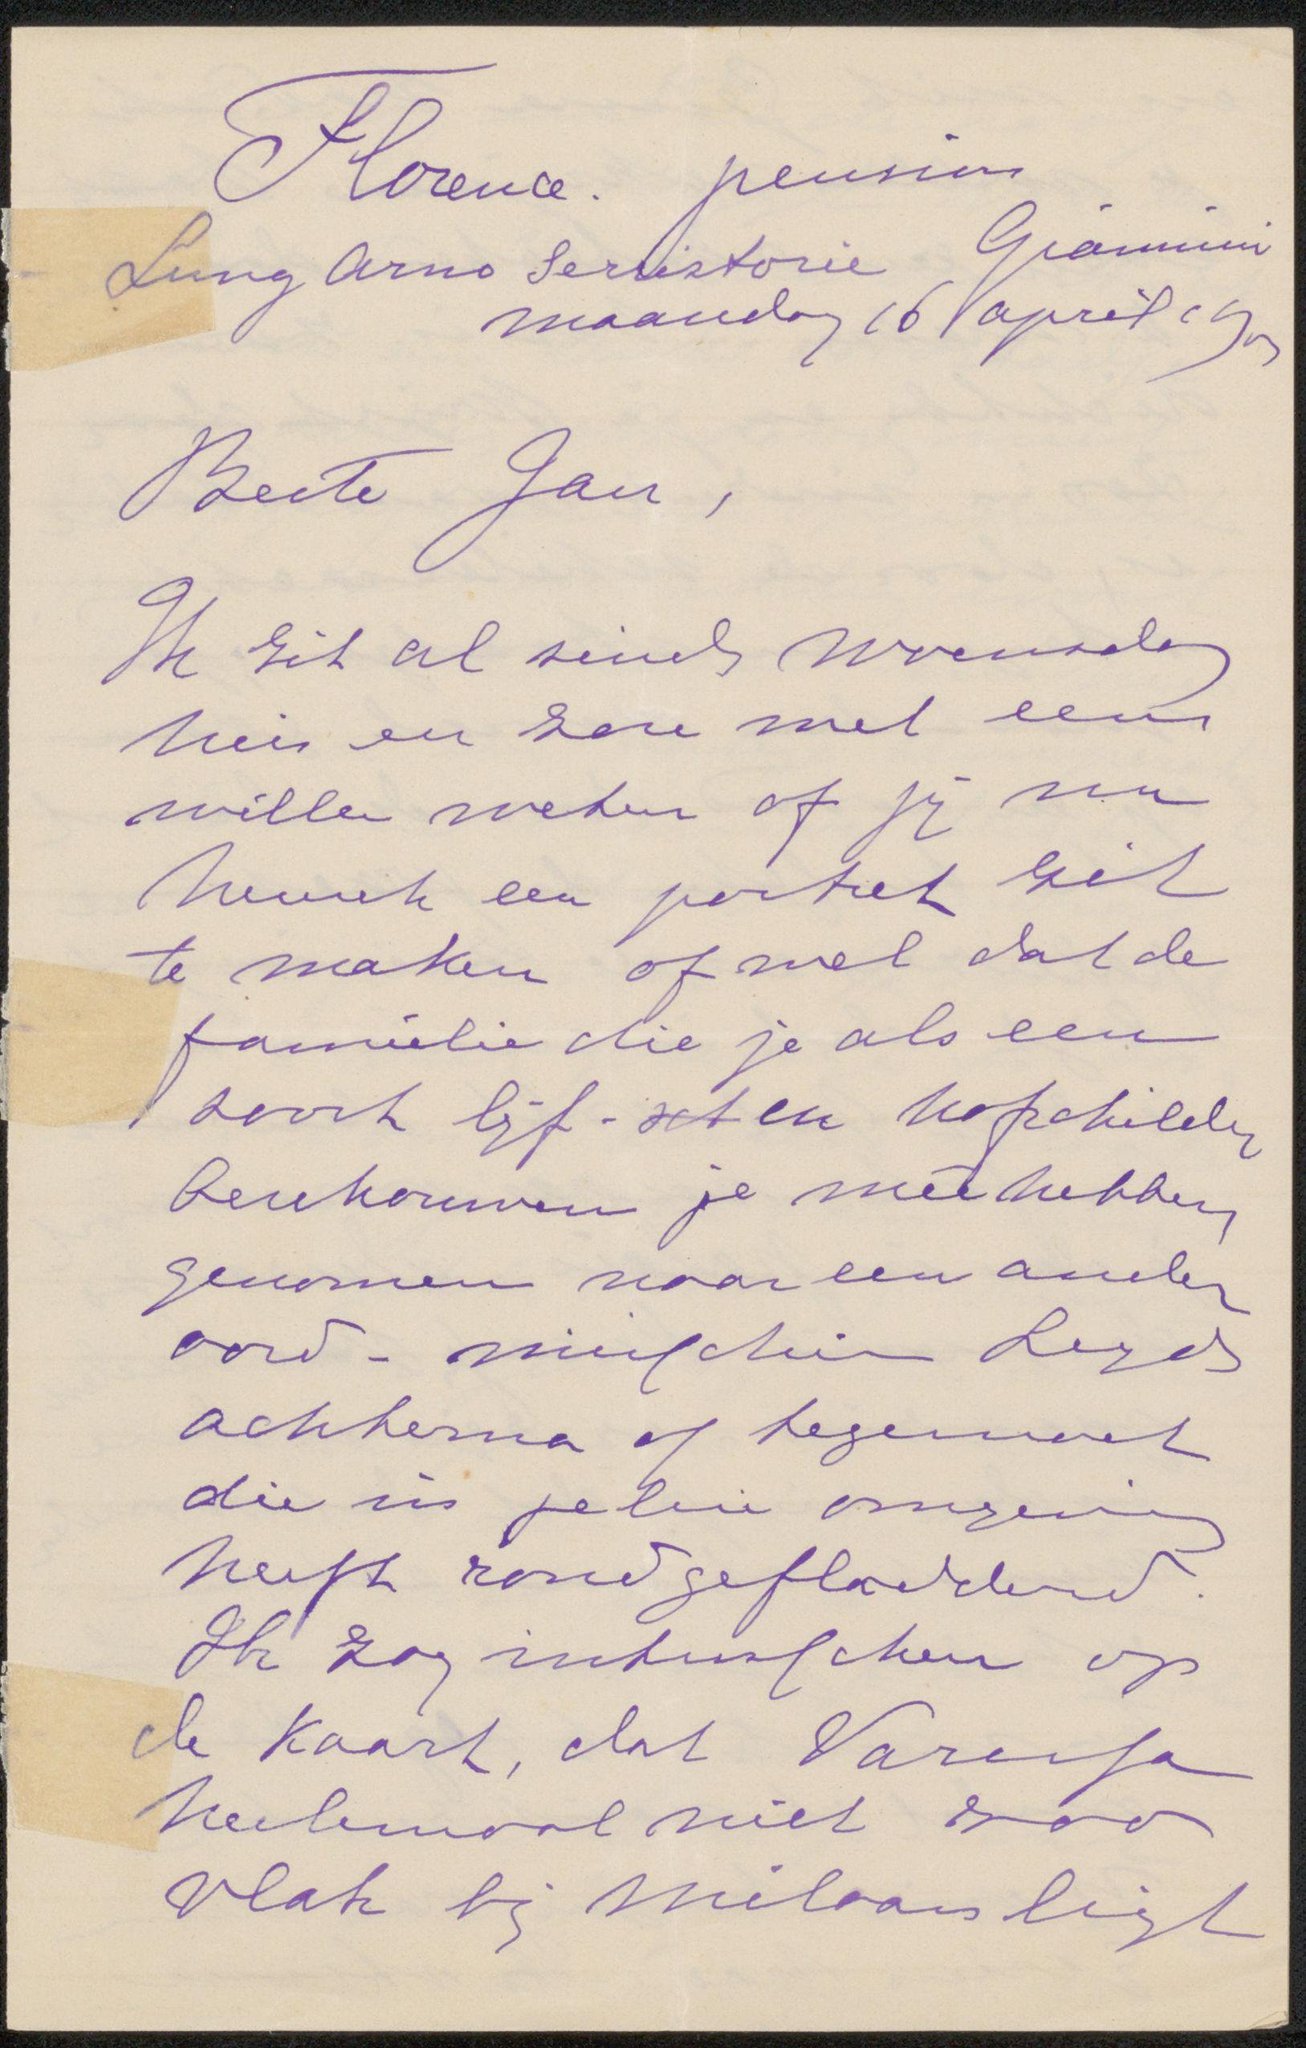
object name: letter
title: Brief aan Jan Veth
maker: etha fles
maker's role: print maker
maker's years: 1857-1948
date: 1900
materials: ink, paper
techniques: pen, writing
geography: florence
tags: dordrecht, amsterdam, painter, print maker, draughtsman, designer, jan veth, italy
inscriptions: collector's mark: ‘RPK’